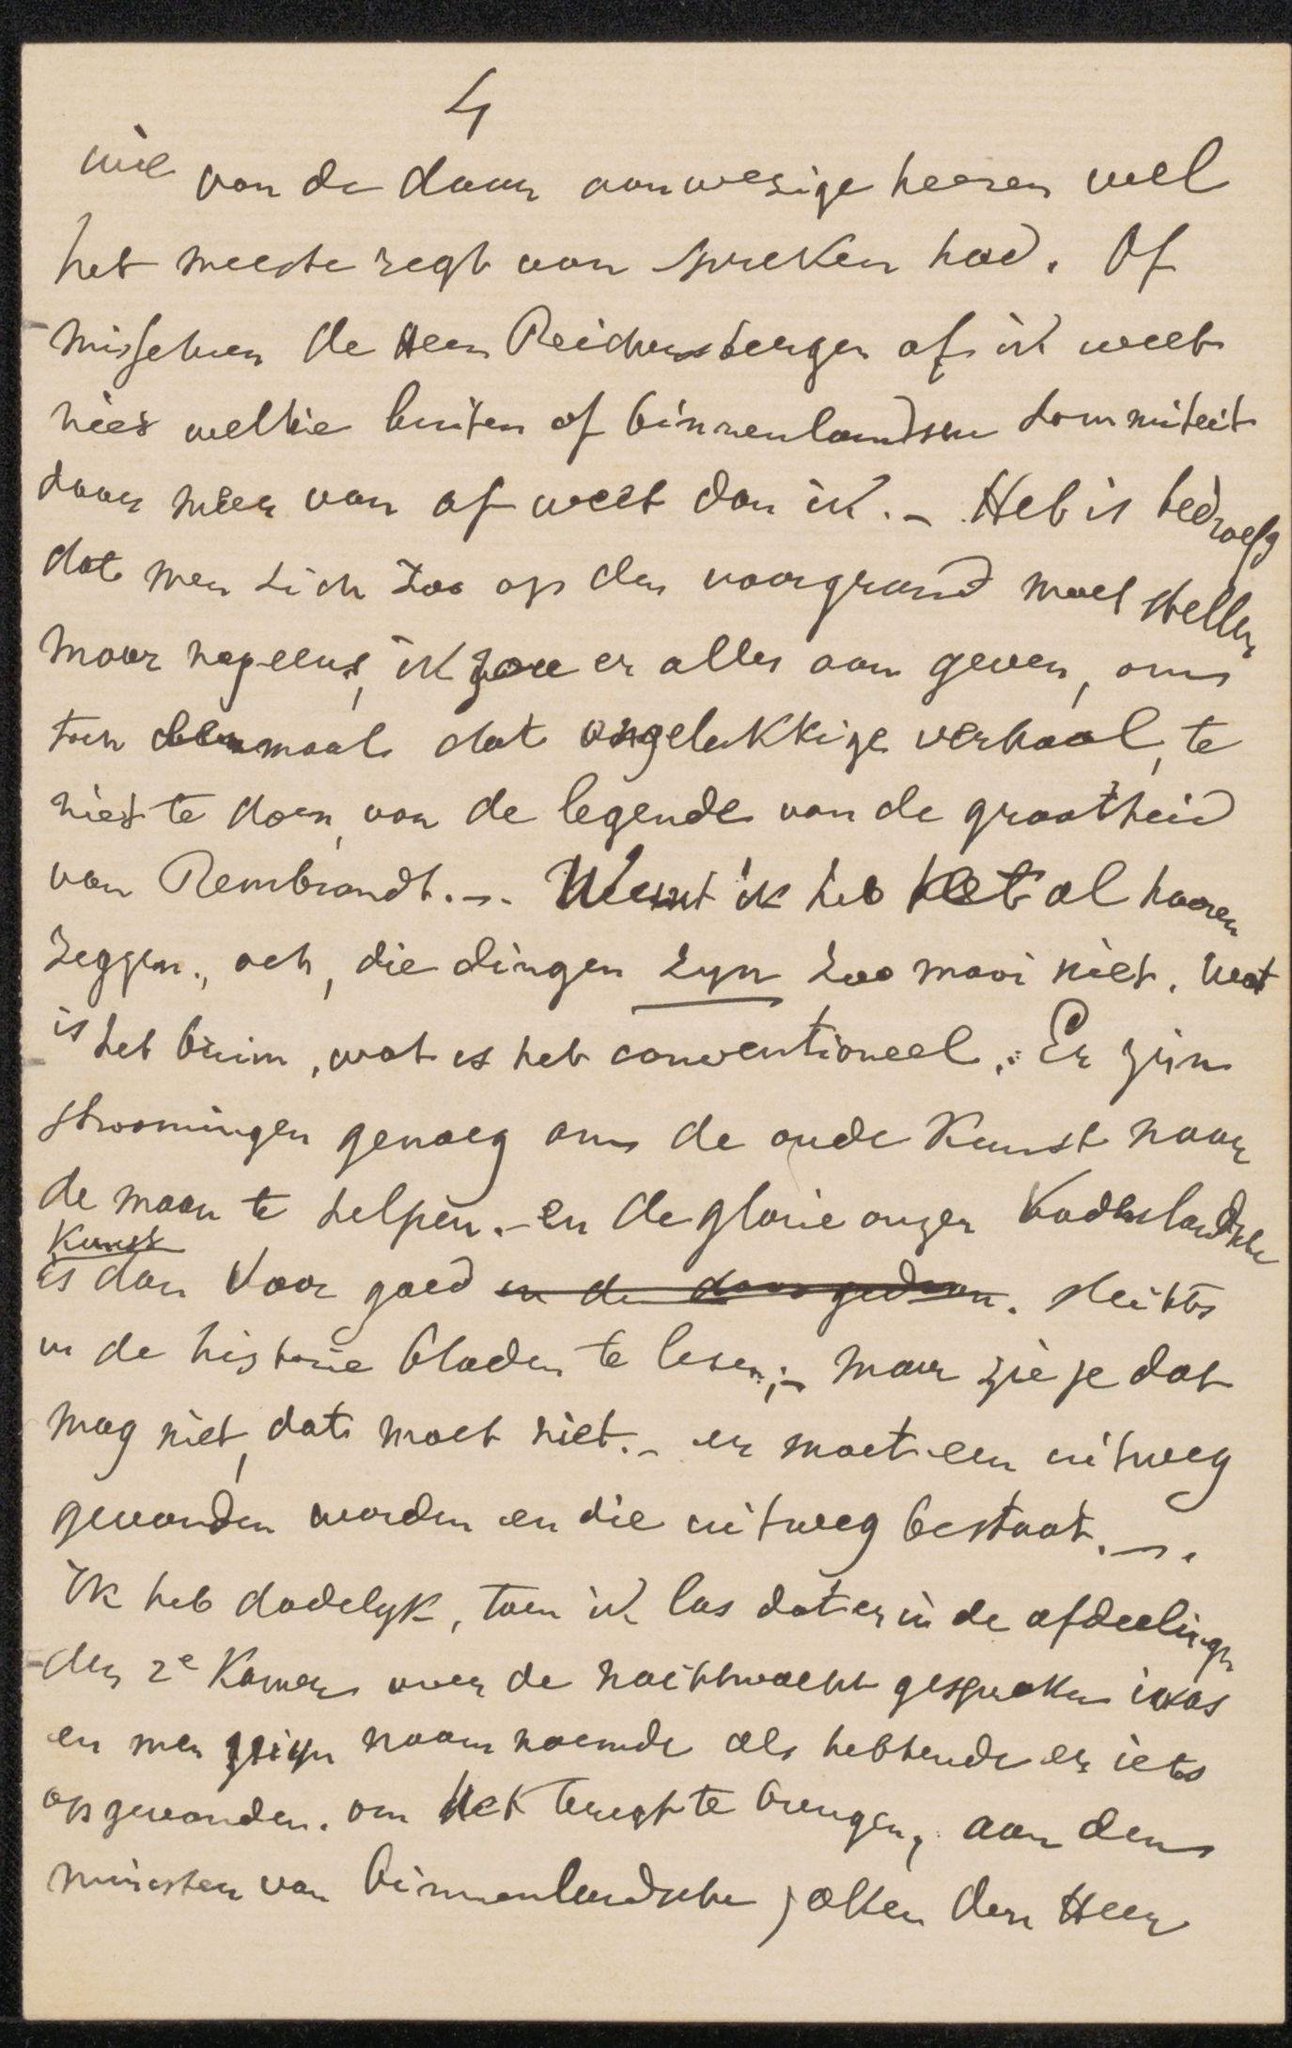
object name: letter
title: Brief aan Jan Veth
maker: jozef israëls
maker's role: draughtsman, painter, print maker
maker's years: 1824-1911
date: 1894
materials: ink, paper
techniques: pen, writing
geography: the hague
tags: jan veth, amsterdam, painter, print maker, draughtsman, rembrandt van rijn, the hague, politician, samuel van houten, painting (including book-illumination, miniature-painting), workshop, studio of the artist (in general)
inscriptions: watermark, collector's mark: ‘RPK’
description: Vormt doorlopende brief met RP-D-1984-40-J.ISRAELS-8.